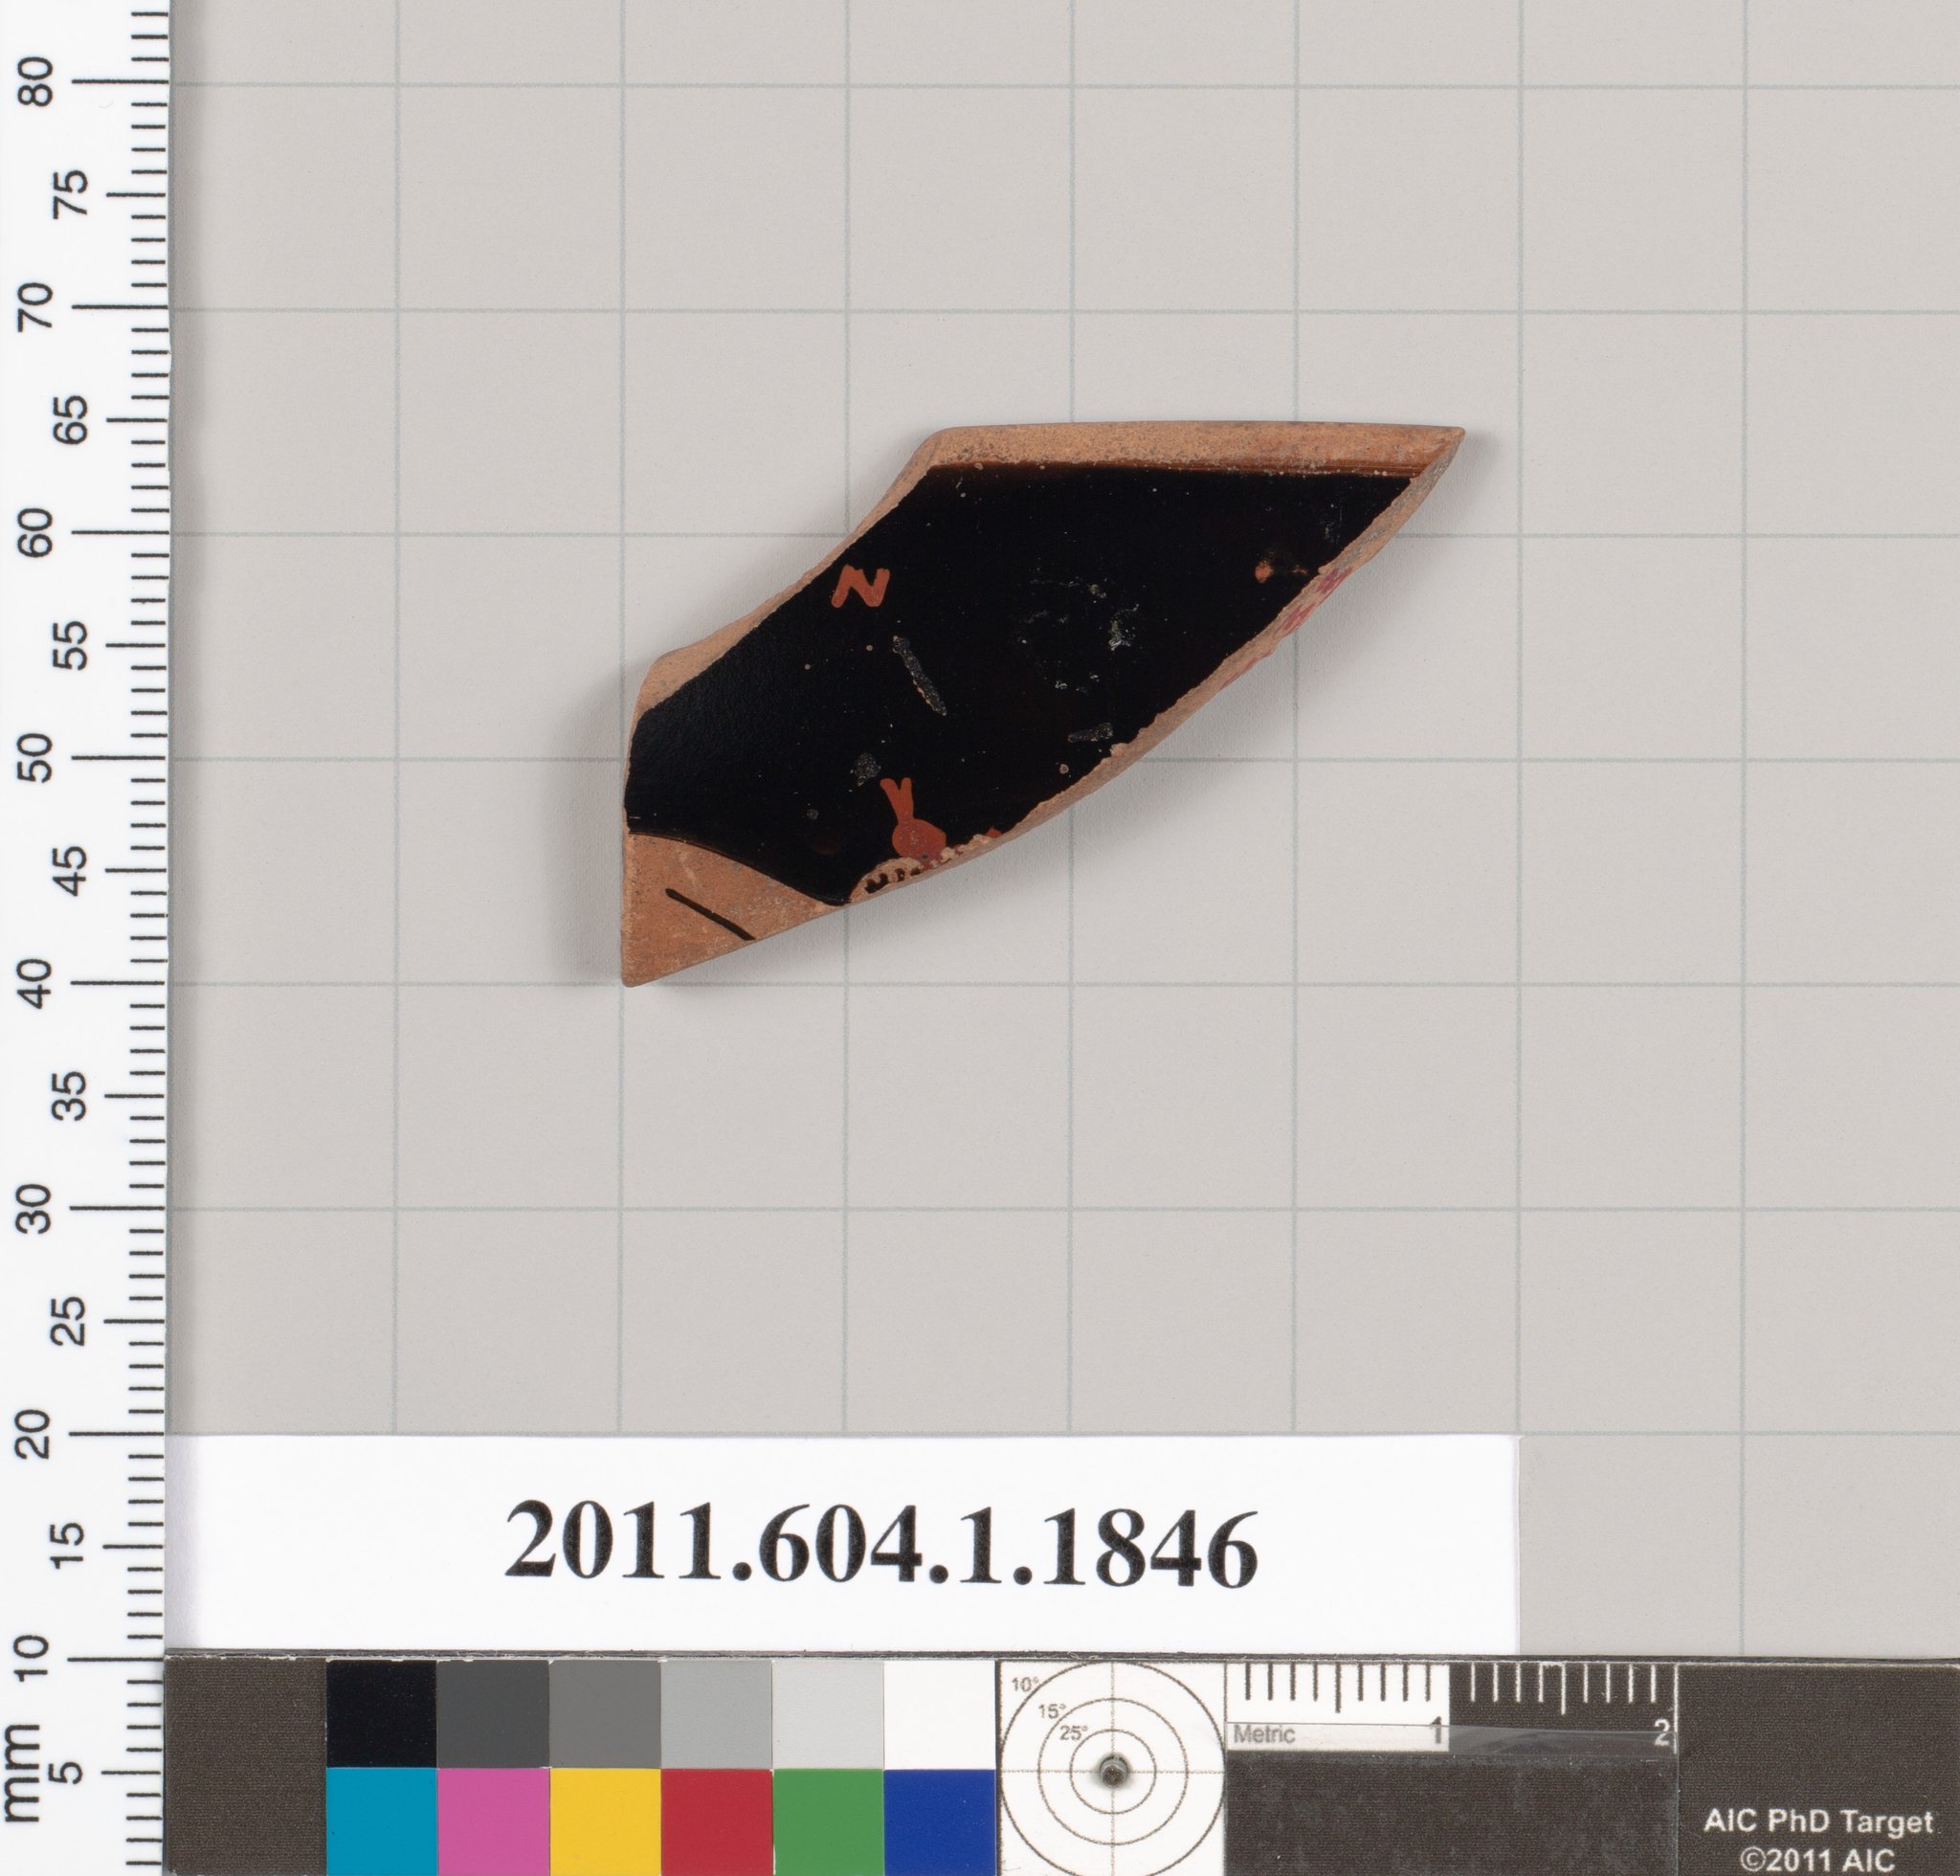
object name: kylix fragment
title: Terracotta rim fragment of a kylix (drinking cup)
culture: greek, attic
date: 534-468 BCE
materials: terracotta